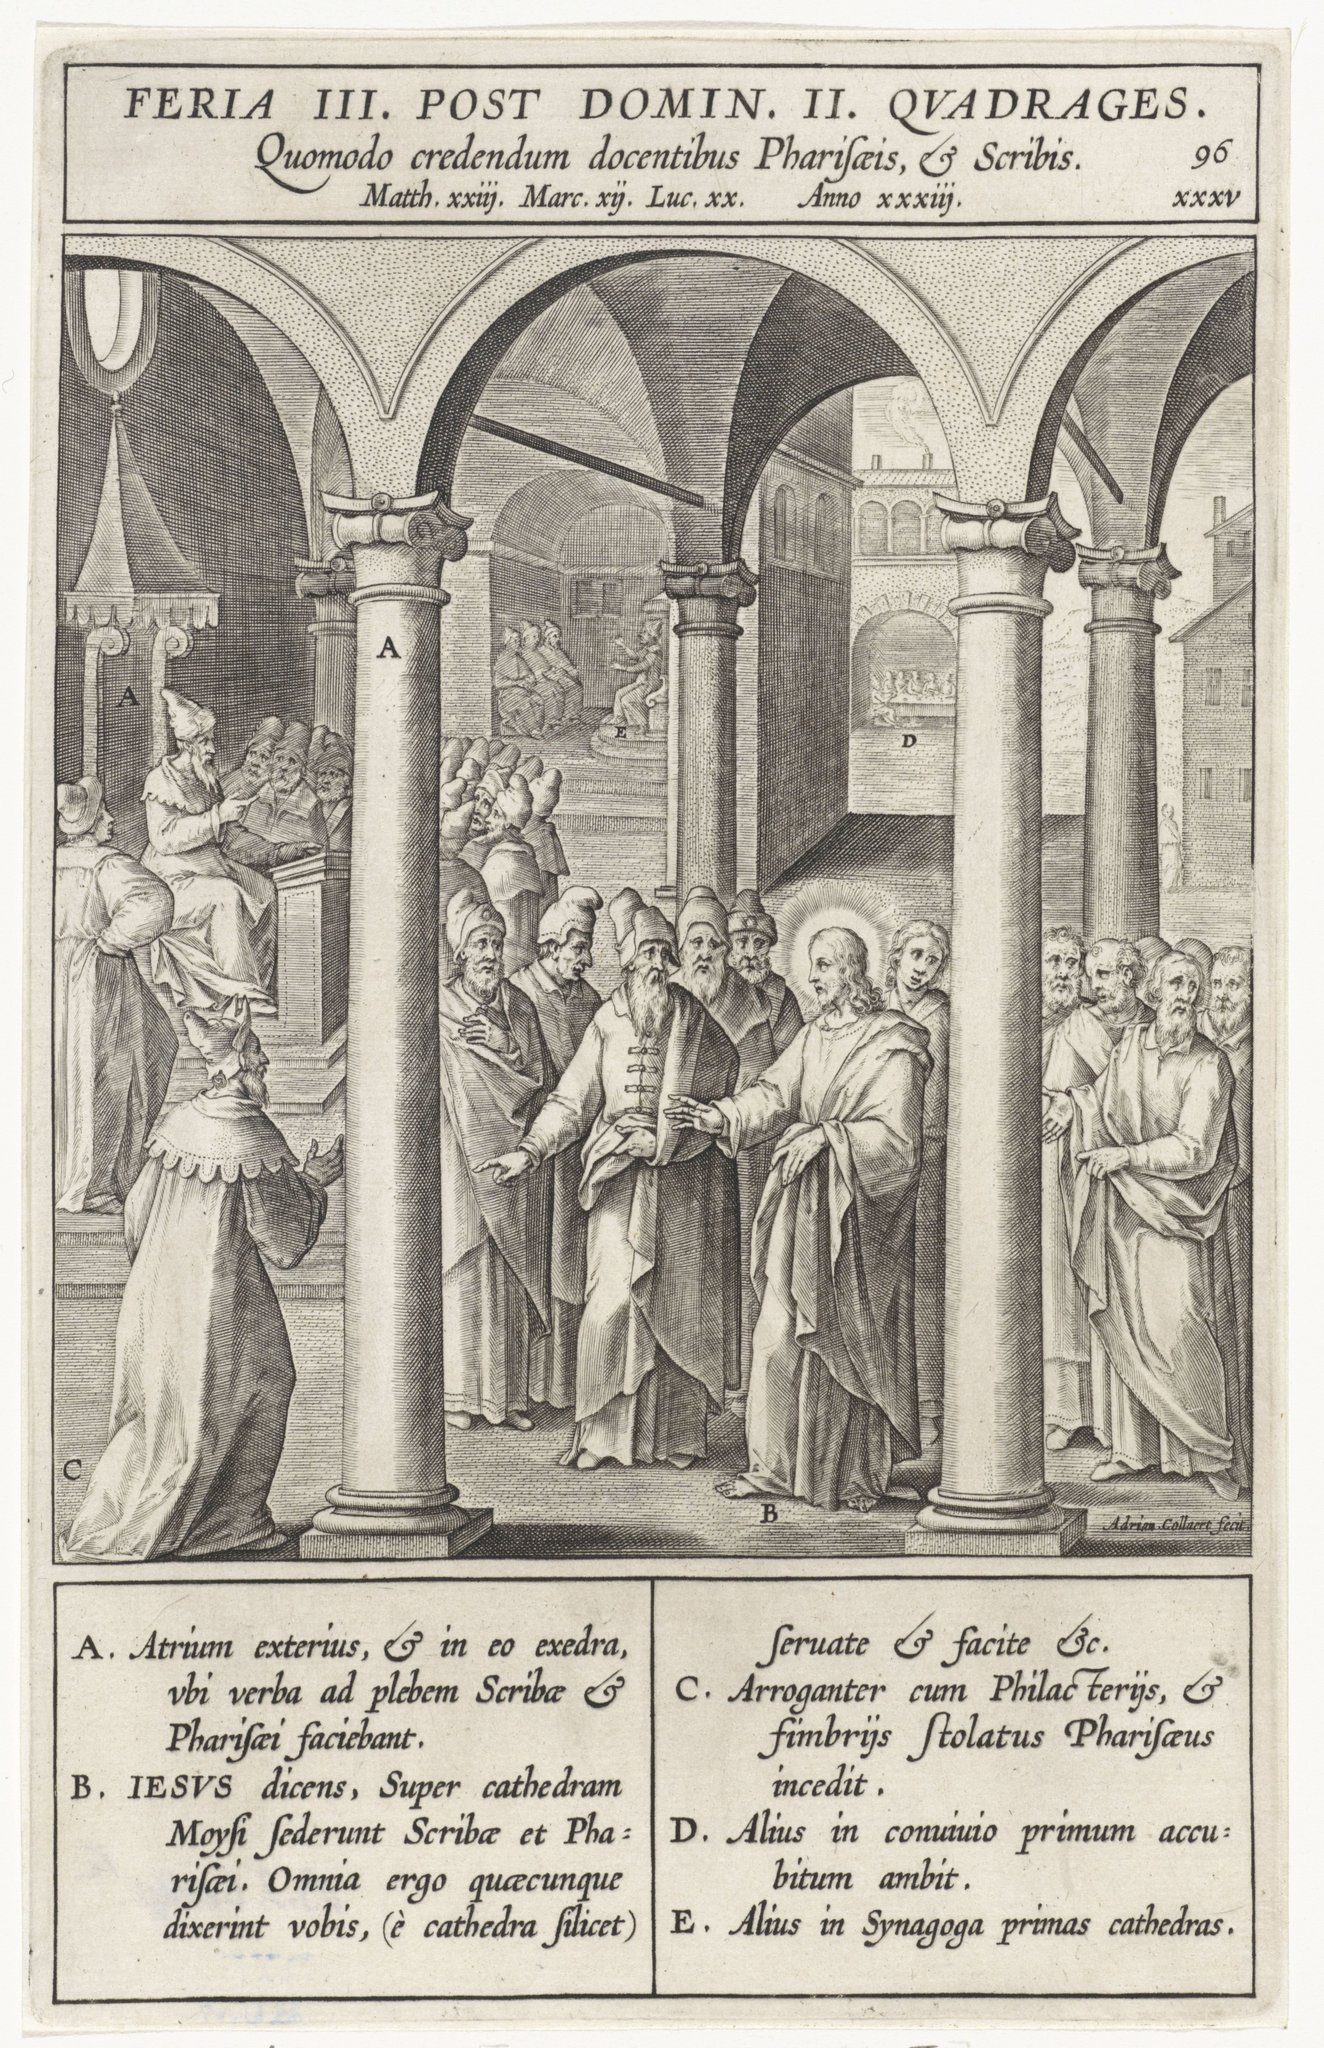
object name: print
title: Feria III. Post Domin. II. Qvadrages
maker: adriaen collaert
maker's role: draughtsman, print maker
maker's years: 1560-1618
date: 1593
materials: paper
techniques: engraving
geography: antwerp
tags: speeches of christ against scribes and pharisees (matthew 23; mark 12:38-40; luke 11:42-52, 20:45-47)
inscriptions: collector's mark: Lugt 2165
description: Christus predikt in de tempel tegenover de schriftgeleerden en de farizeeën. Bij verschillende elementen uit de voorstelling staan letters die corresponderen met de legenda in de marge.